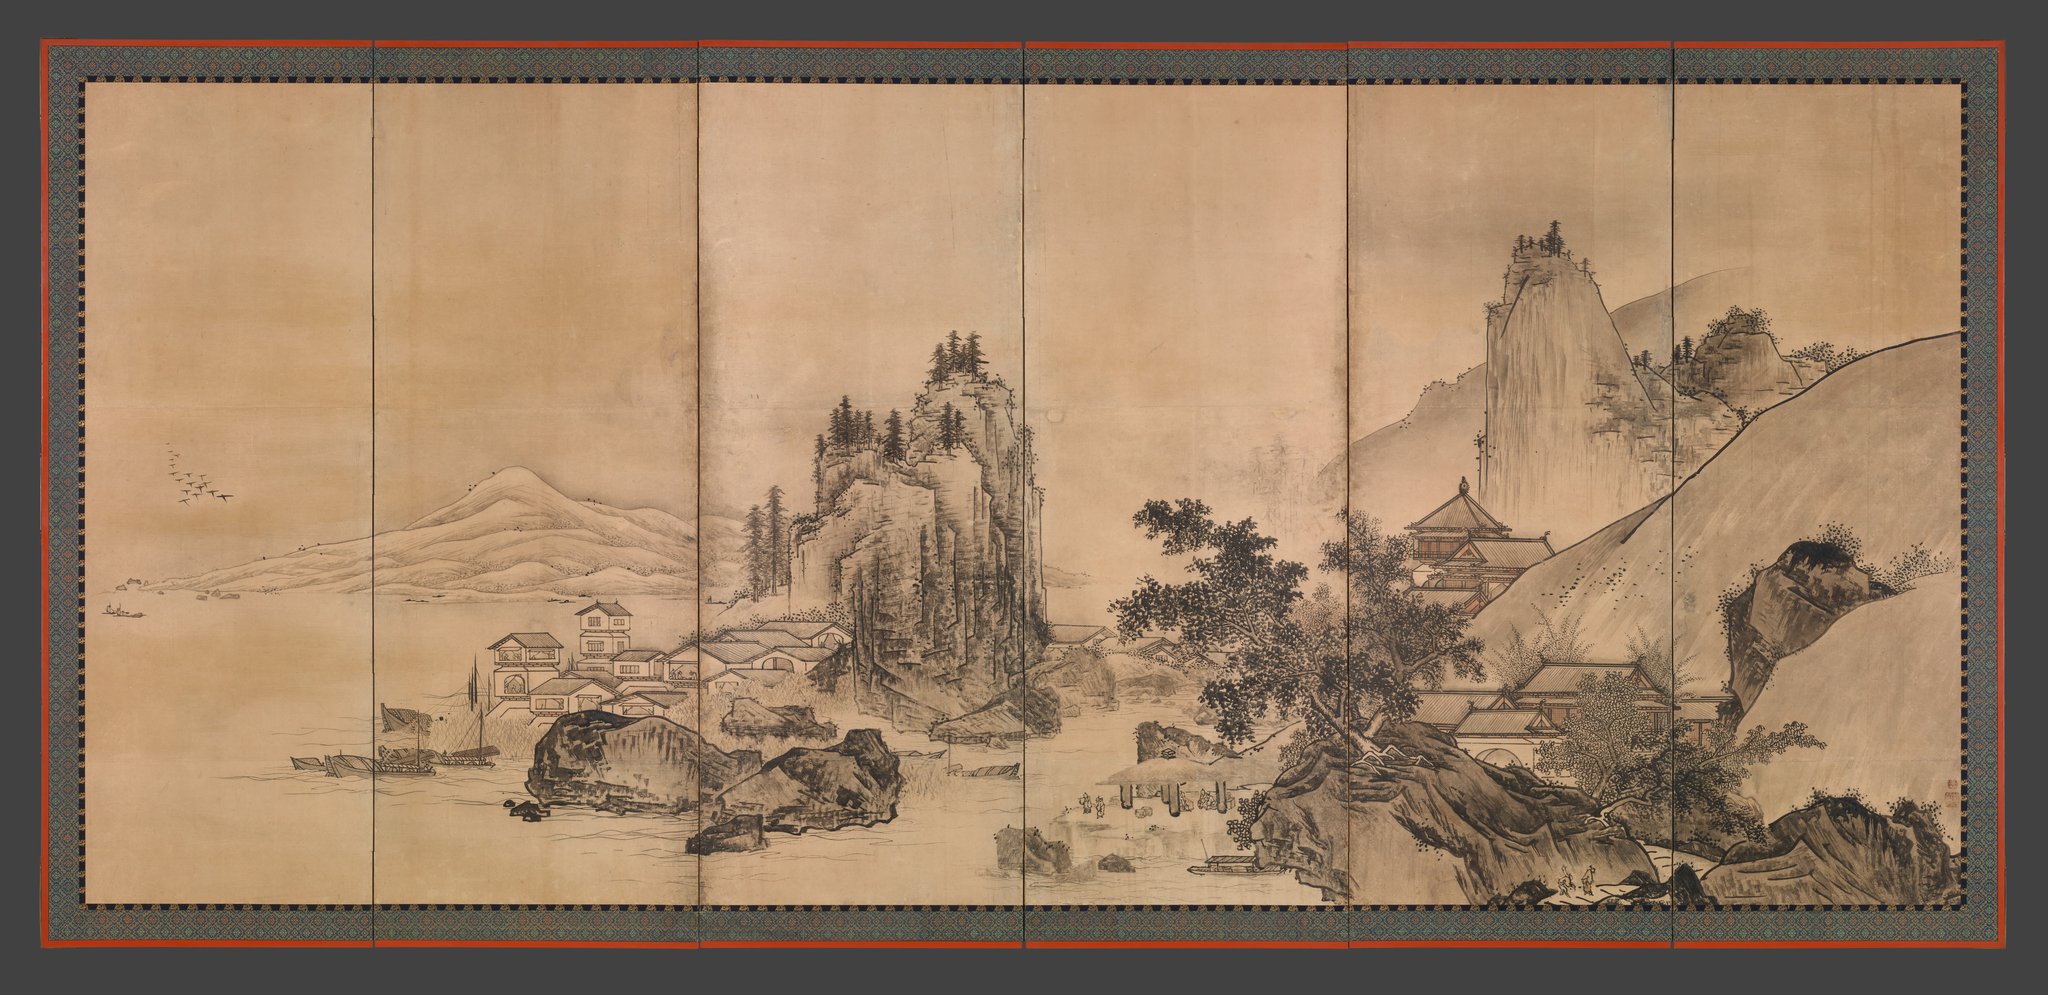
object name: screen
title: Landscape of the Four Seasons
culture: japanese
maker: unkoku tōgan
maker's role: artist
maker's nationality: japanese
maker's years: 1547-1618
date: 1567-1633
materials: gold, ink, panel, paper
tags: houses,hills,landscapes,trees